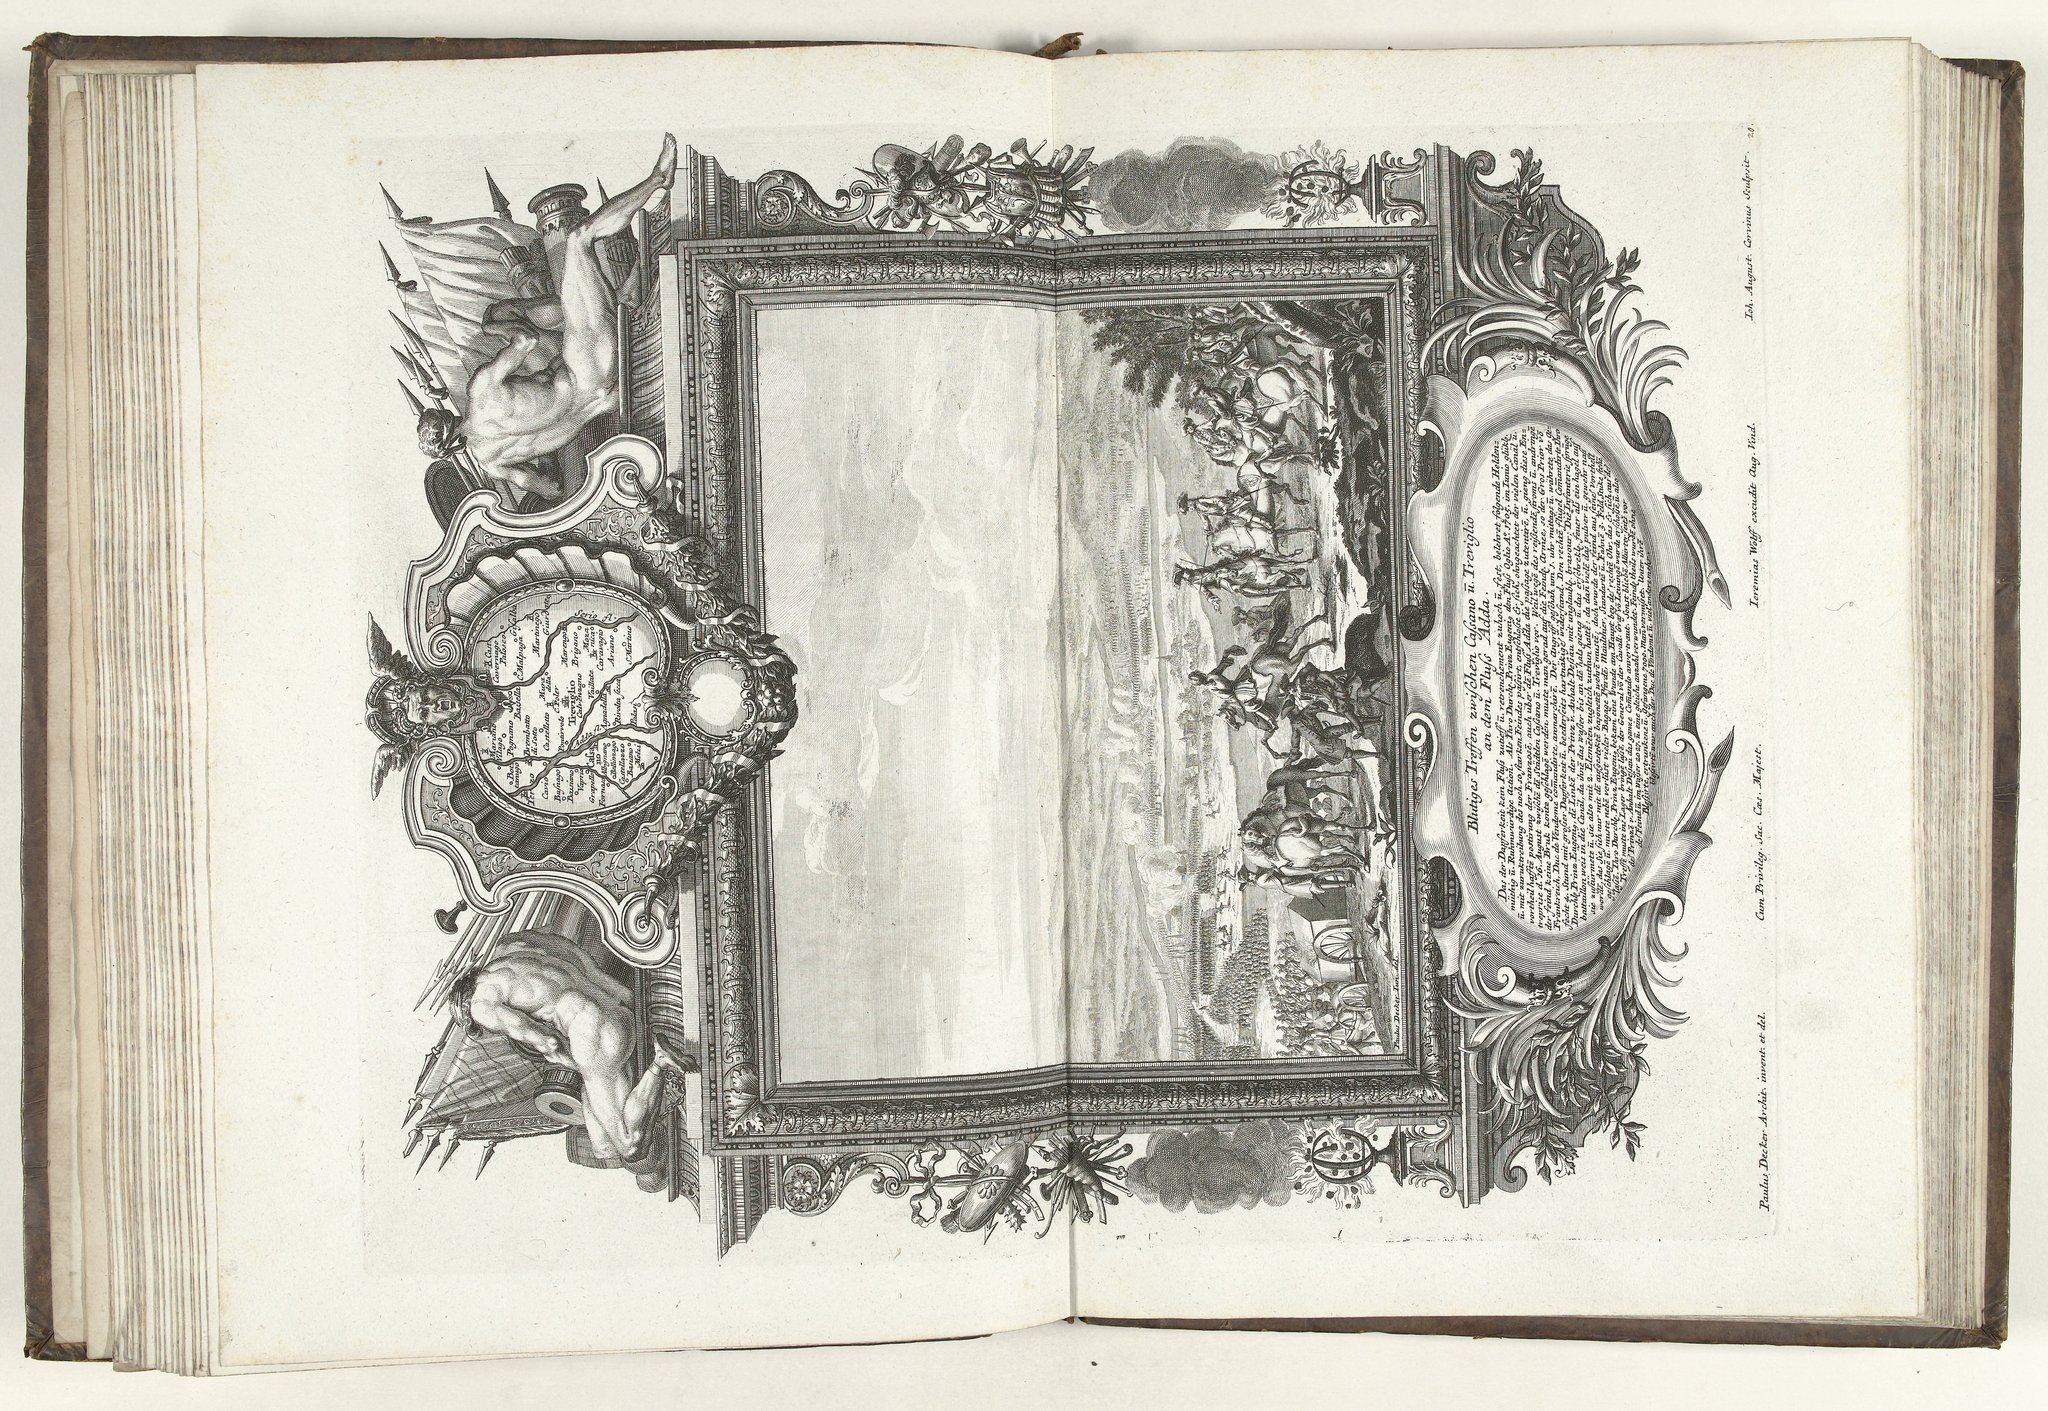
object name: print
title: Blutiges Treffen zwischen Cassano u. Treviglio an dem Fluss Adda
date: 1712-1715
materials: paper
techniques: engraving, etching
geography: augsburg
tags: paris, vienna, eugenius van savoye, battle (+ land forces)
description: Veldslag bij Cassano d'Adda in Lombardije, tussen de Geallieerden onder de prins van Savoye en de Fransen onder de hertog van Vendome, 16 augustus 1705. Rechthoekige voorstelling in een rijk versierde ornamentele omlijsting met bovenaan een cartouche met een kaartje van het gebied tussen twee naakte mannen. Onderaan en cartouche met de beschrijving van het gevecht in het Duits. Blad in de gebonden verzameling platen uitgebracht onder de titel: Repraesentatio belli ... Der Spanische Successions-Krieg [ca. 1720].